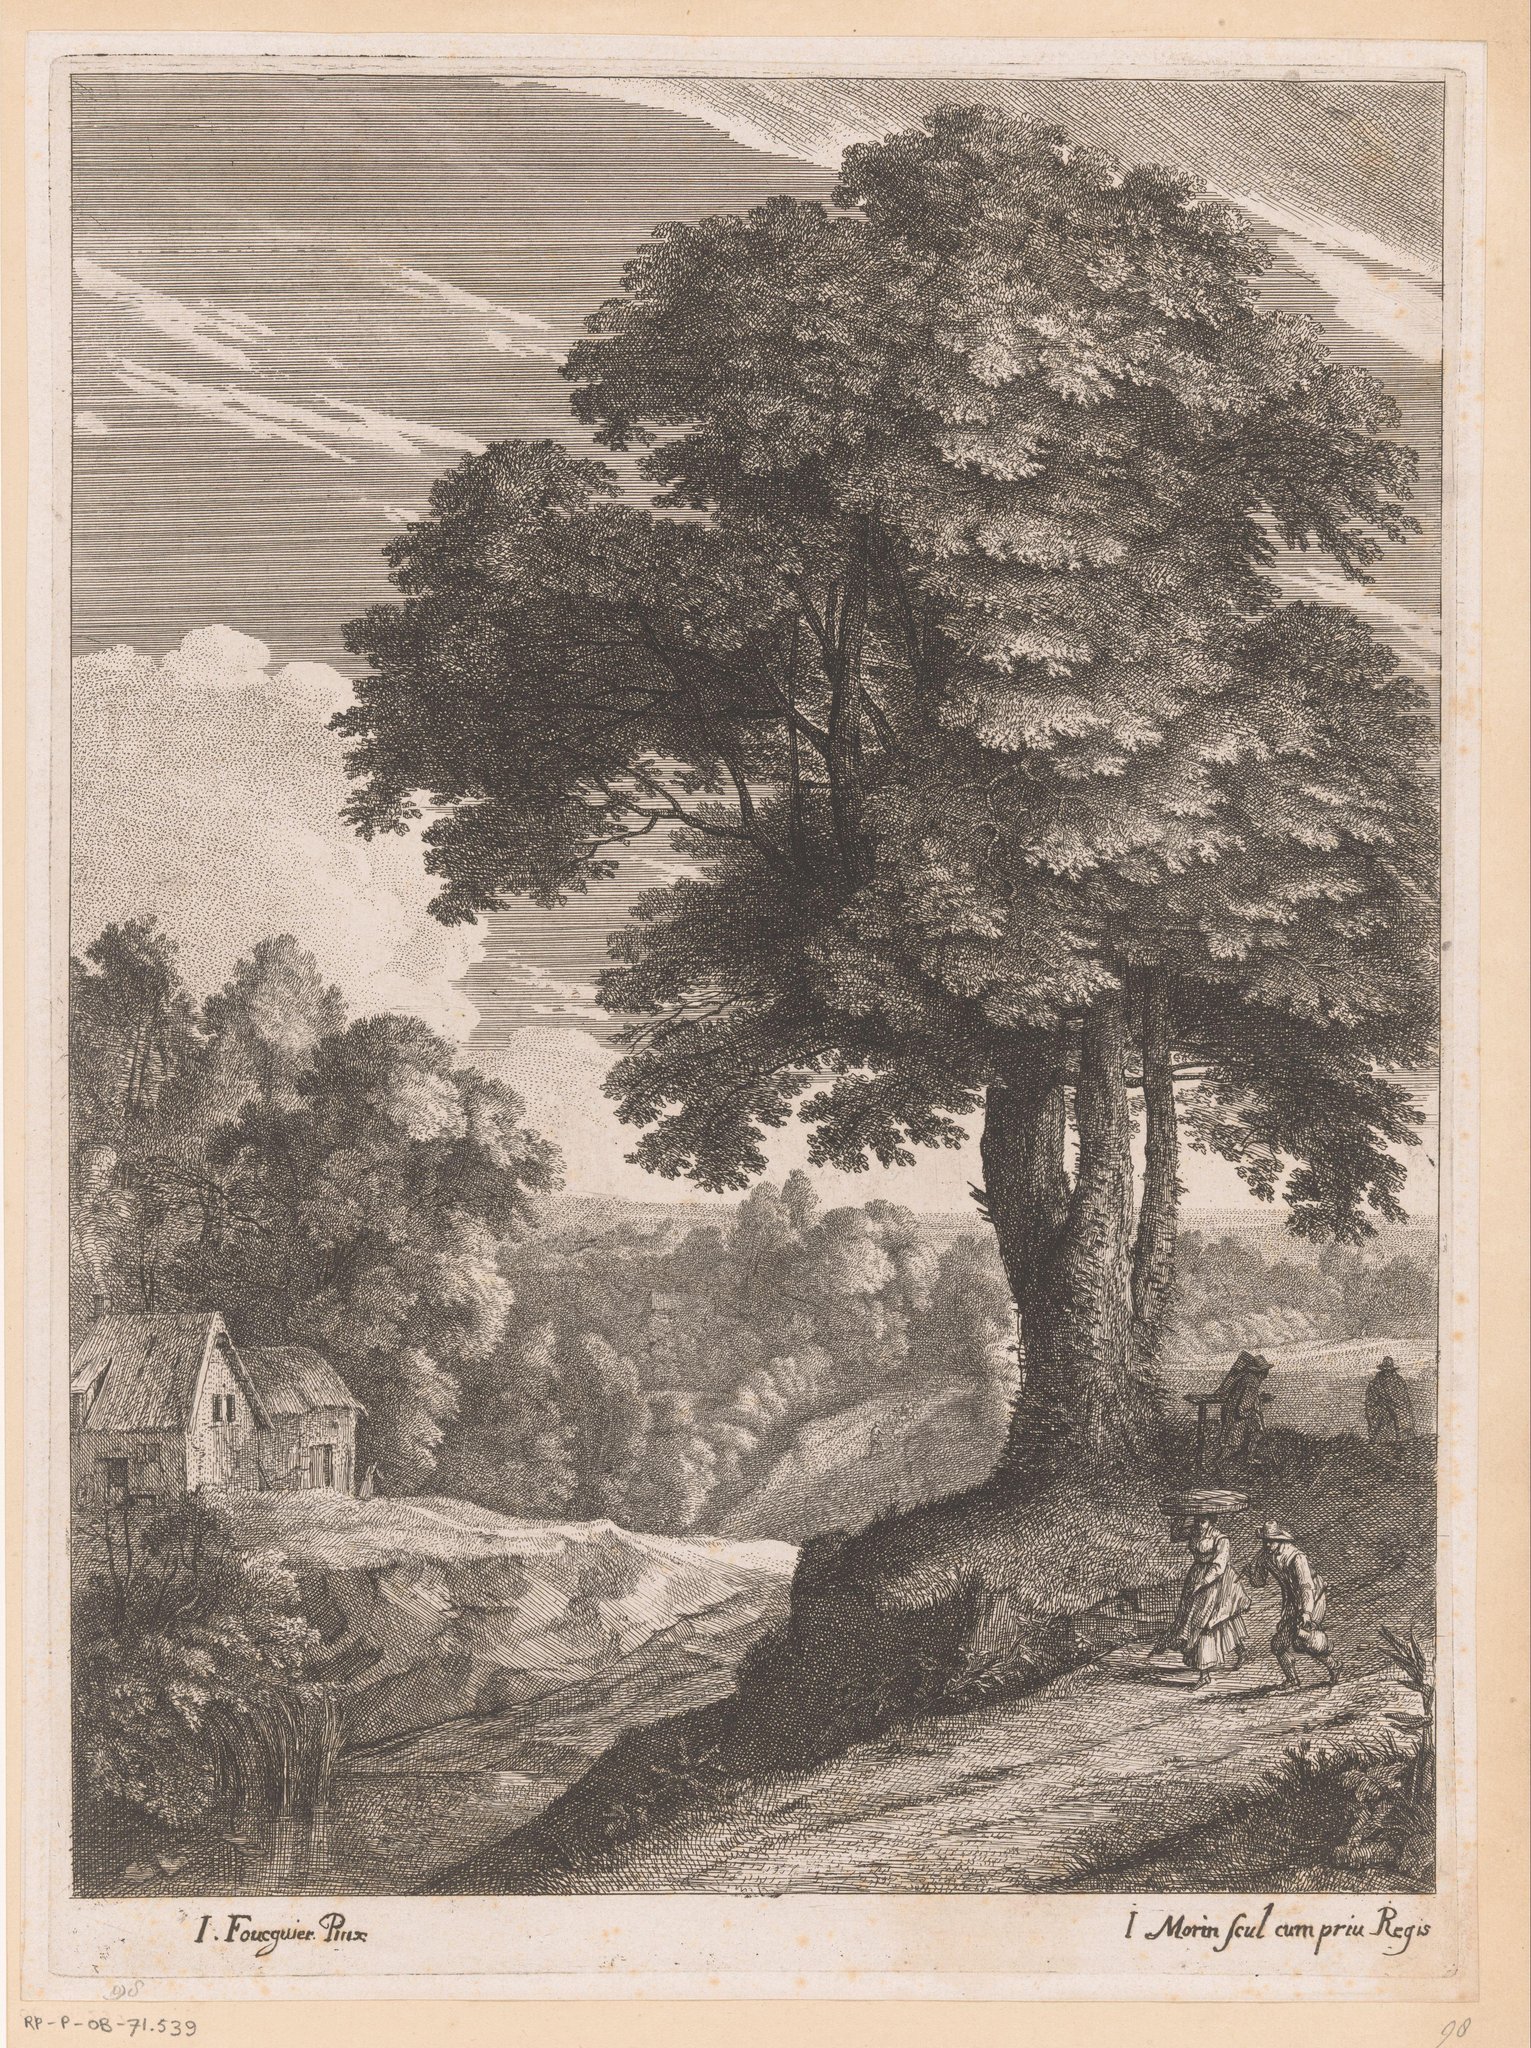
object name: print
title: Landschap met figuren langs een pad bij een boom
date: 1625-1650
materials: paper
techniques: engraving, etching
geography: france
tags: road, path, landscapes in the temperate zone (+ landscape with figures, staffage)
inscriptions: collector's mark: Lugt 240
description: Maakt deel uit van een vierdelige serie met landschappen met hoge bomen.